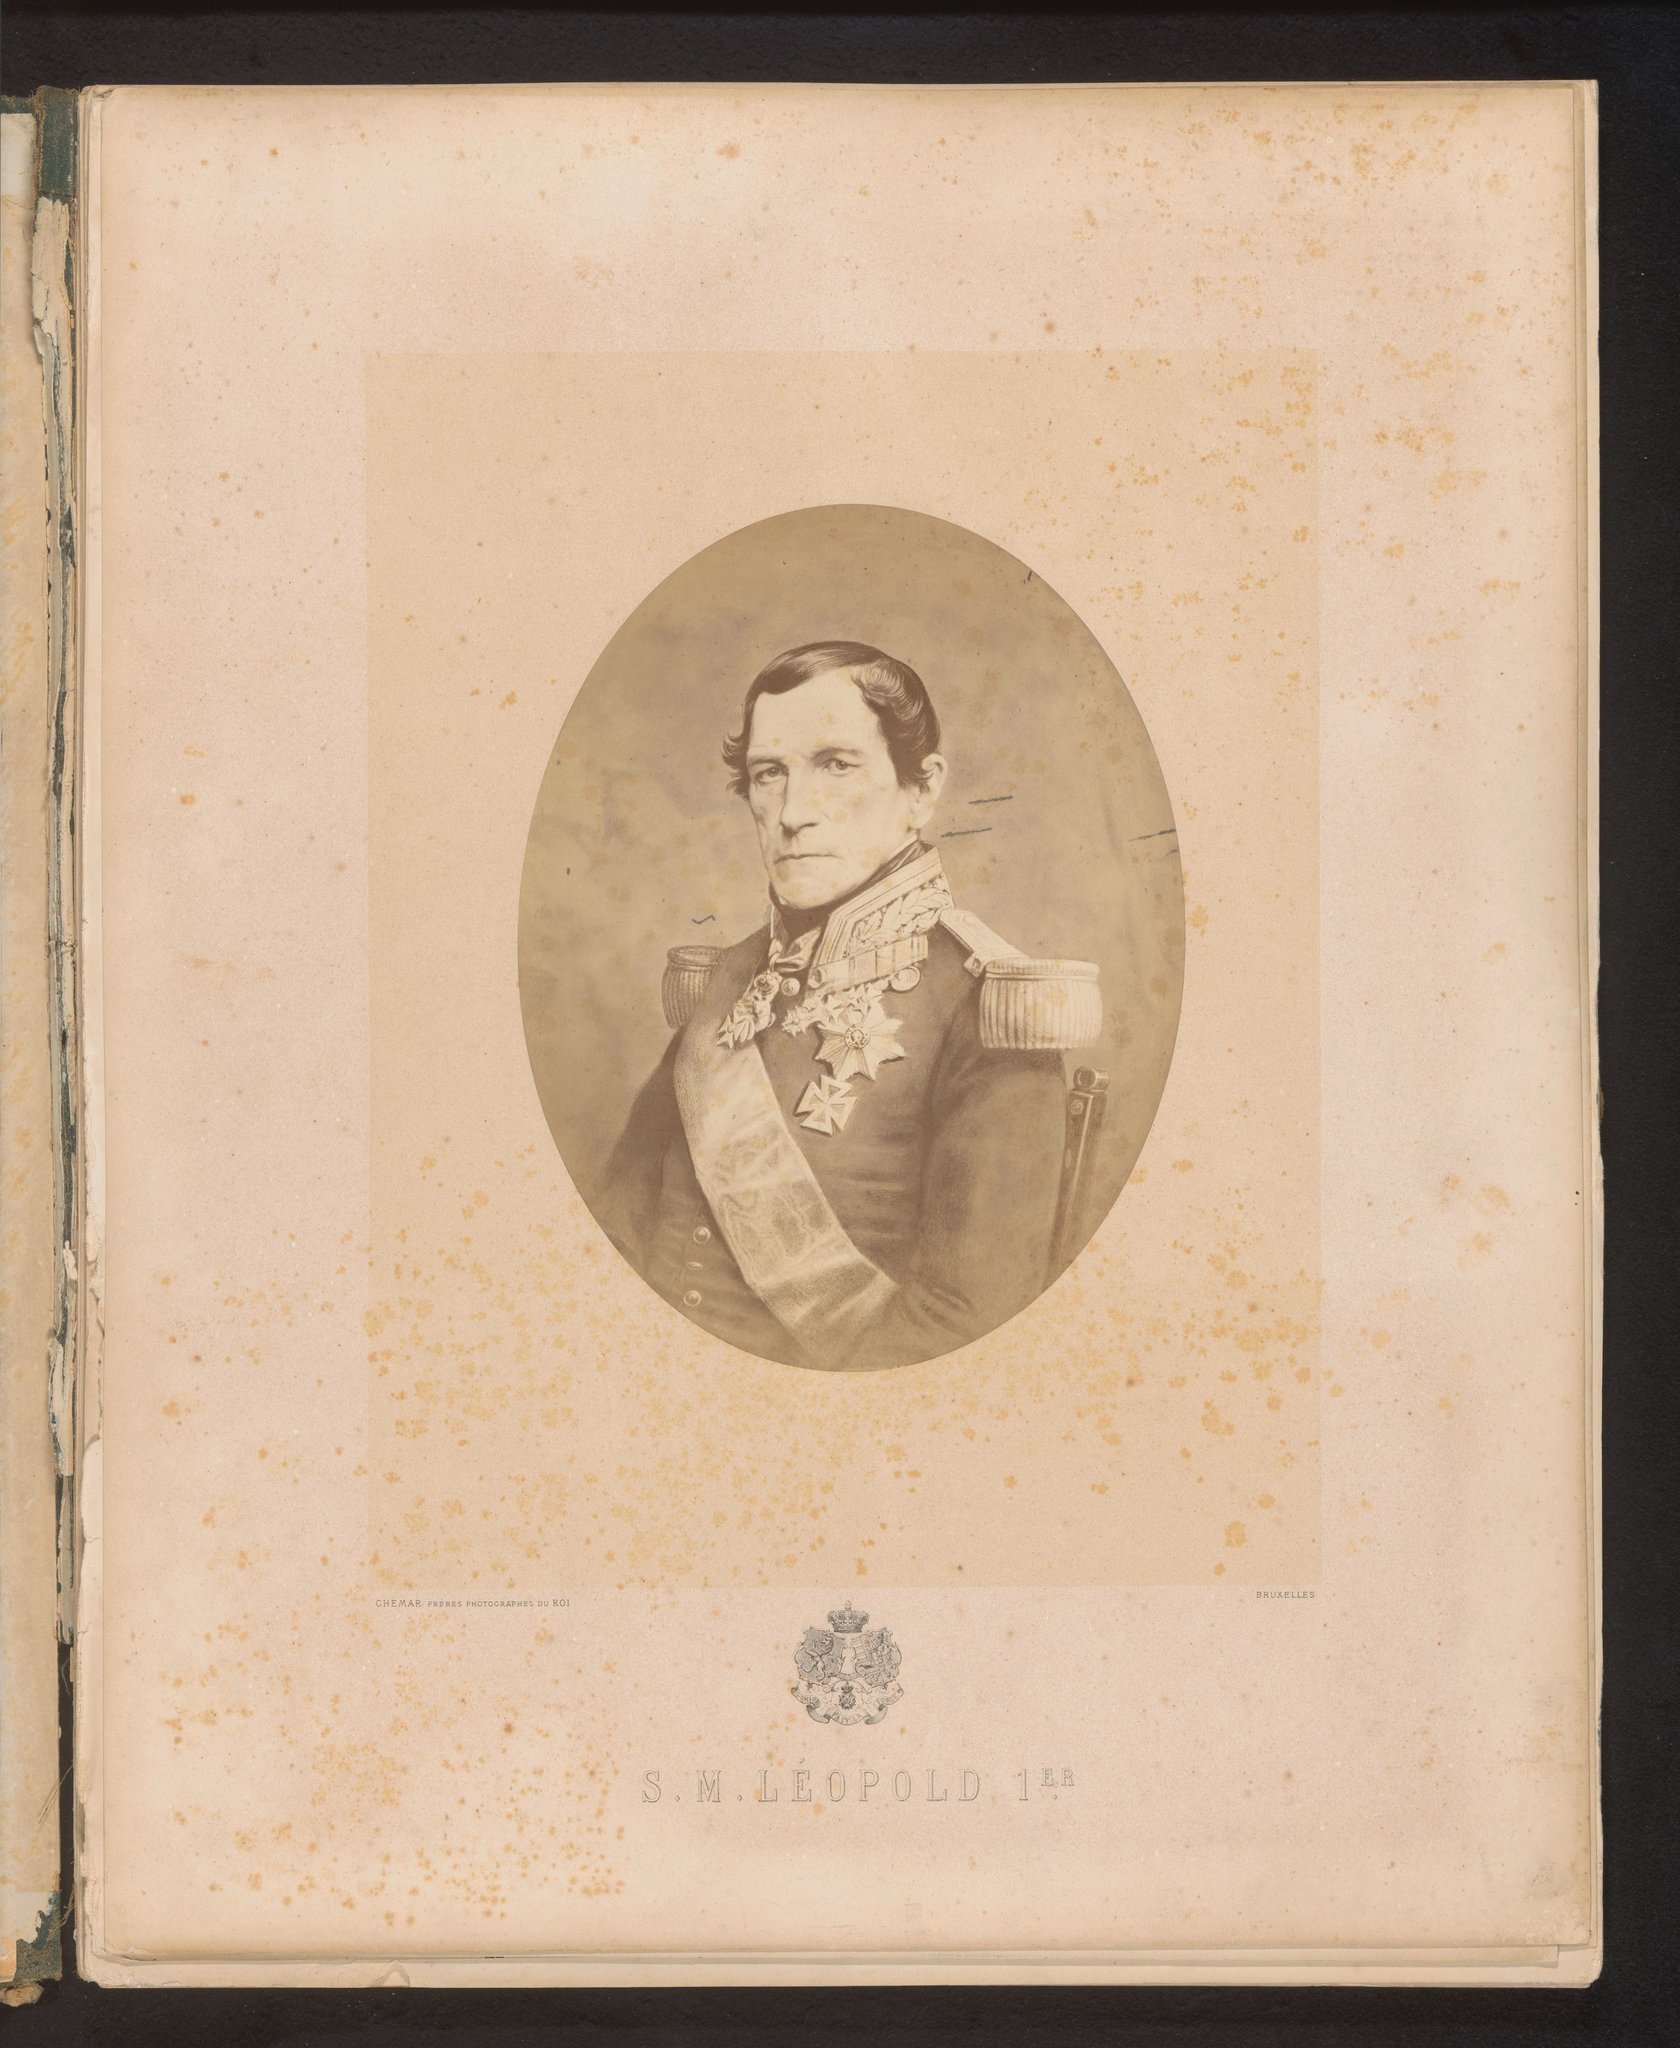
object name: photograph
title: Portret van koning Léopold I van België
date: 1861-1865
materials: photographic support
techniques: albumen print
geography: brussels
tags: laeken, leopold i (koning der belgen), historical persons, king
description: Deze foto maakt deel uit van een omslag met veertien foto's.